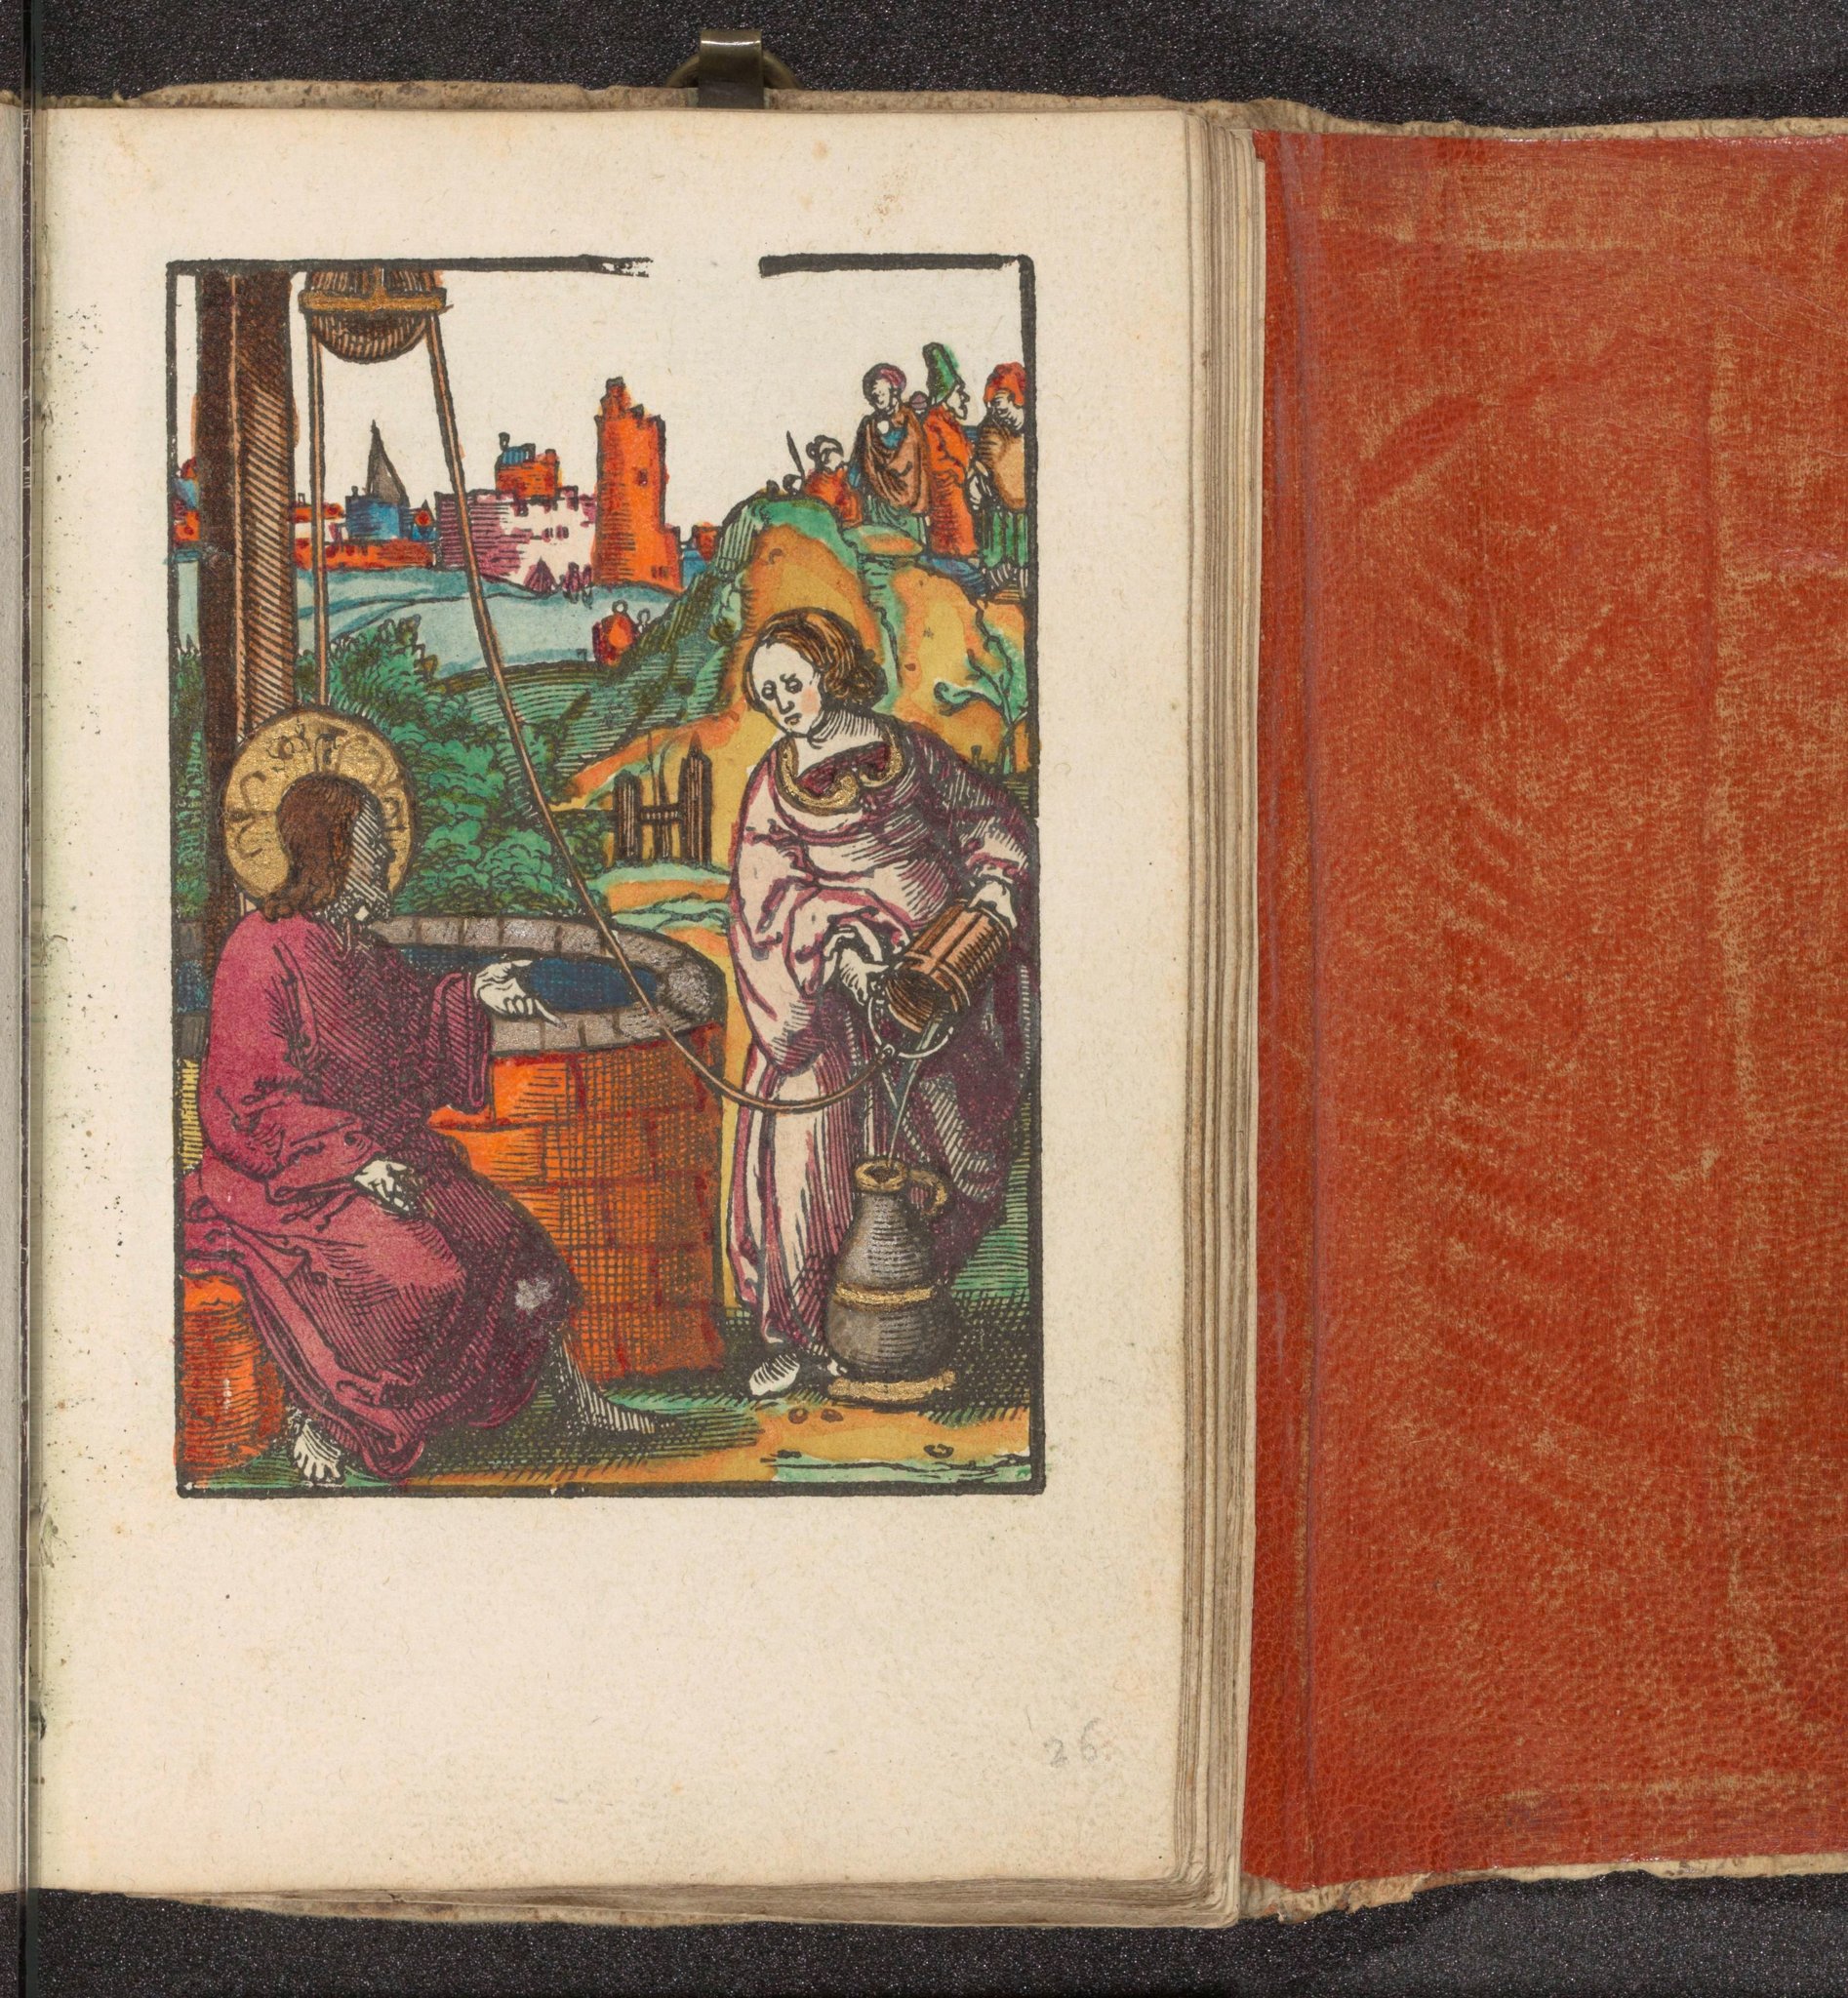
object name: album leaf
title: Christus en de Samaritaanse vrouw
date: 1530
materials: paper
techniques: hand coloring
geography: amsterdam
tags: christ and the woman of samaria: sitting at jacob's well he asks her for a drink from her jug, book in which illustrations are essential, christ resting at jacob's well, after having sent his disciples to sychar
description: Christus rust bij de Jakobsbron, nadat hij zijn discipelen naar de stad heeft gestuurd. Rechts vertrekken zij richting de stad. Een Samaritaanse vrouw komt om water te putten en spreekt met Christus. Prent maakt deel uit van een boek.